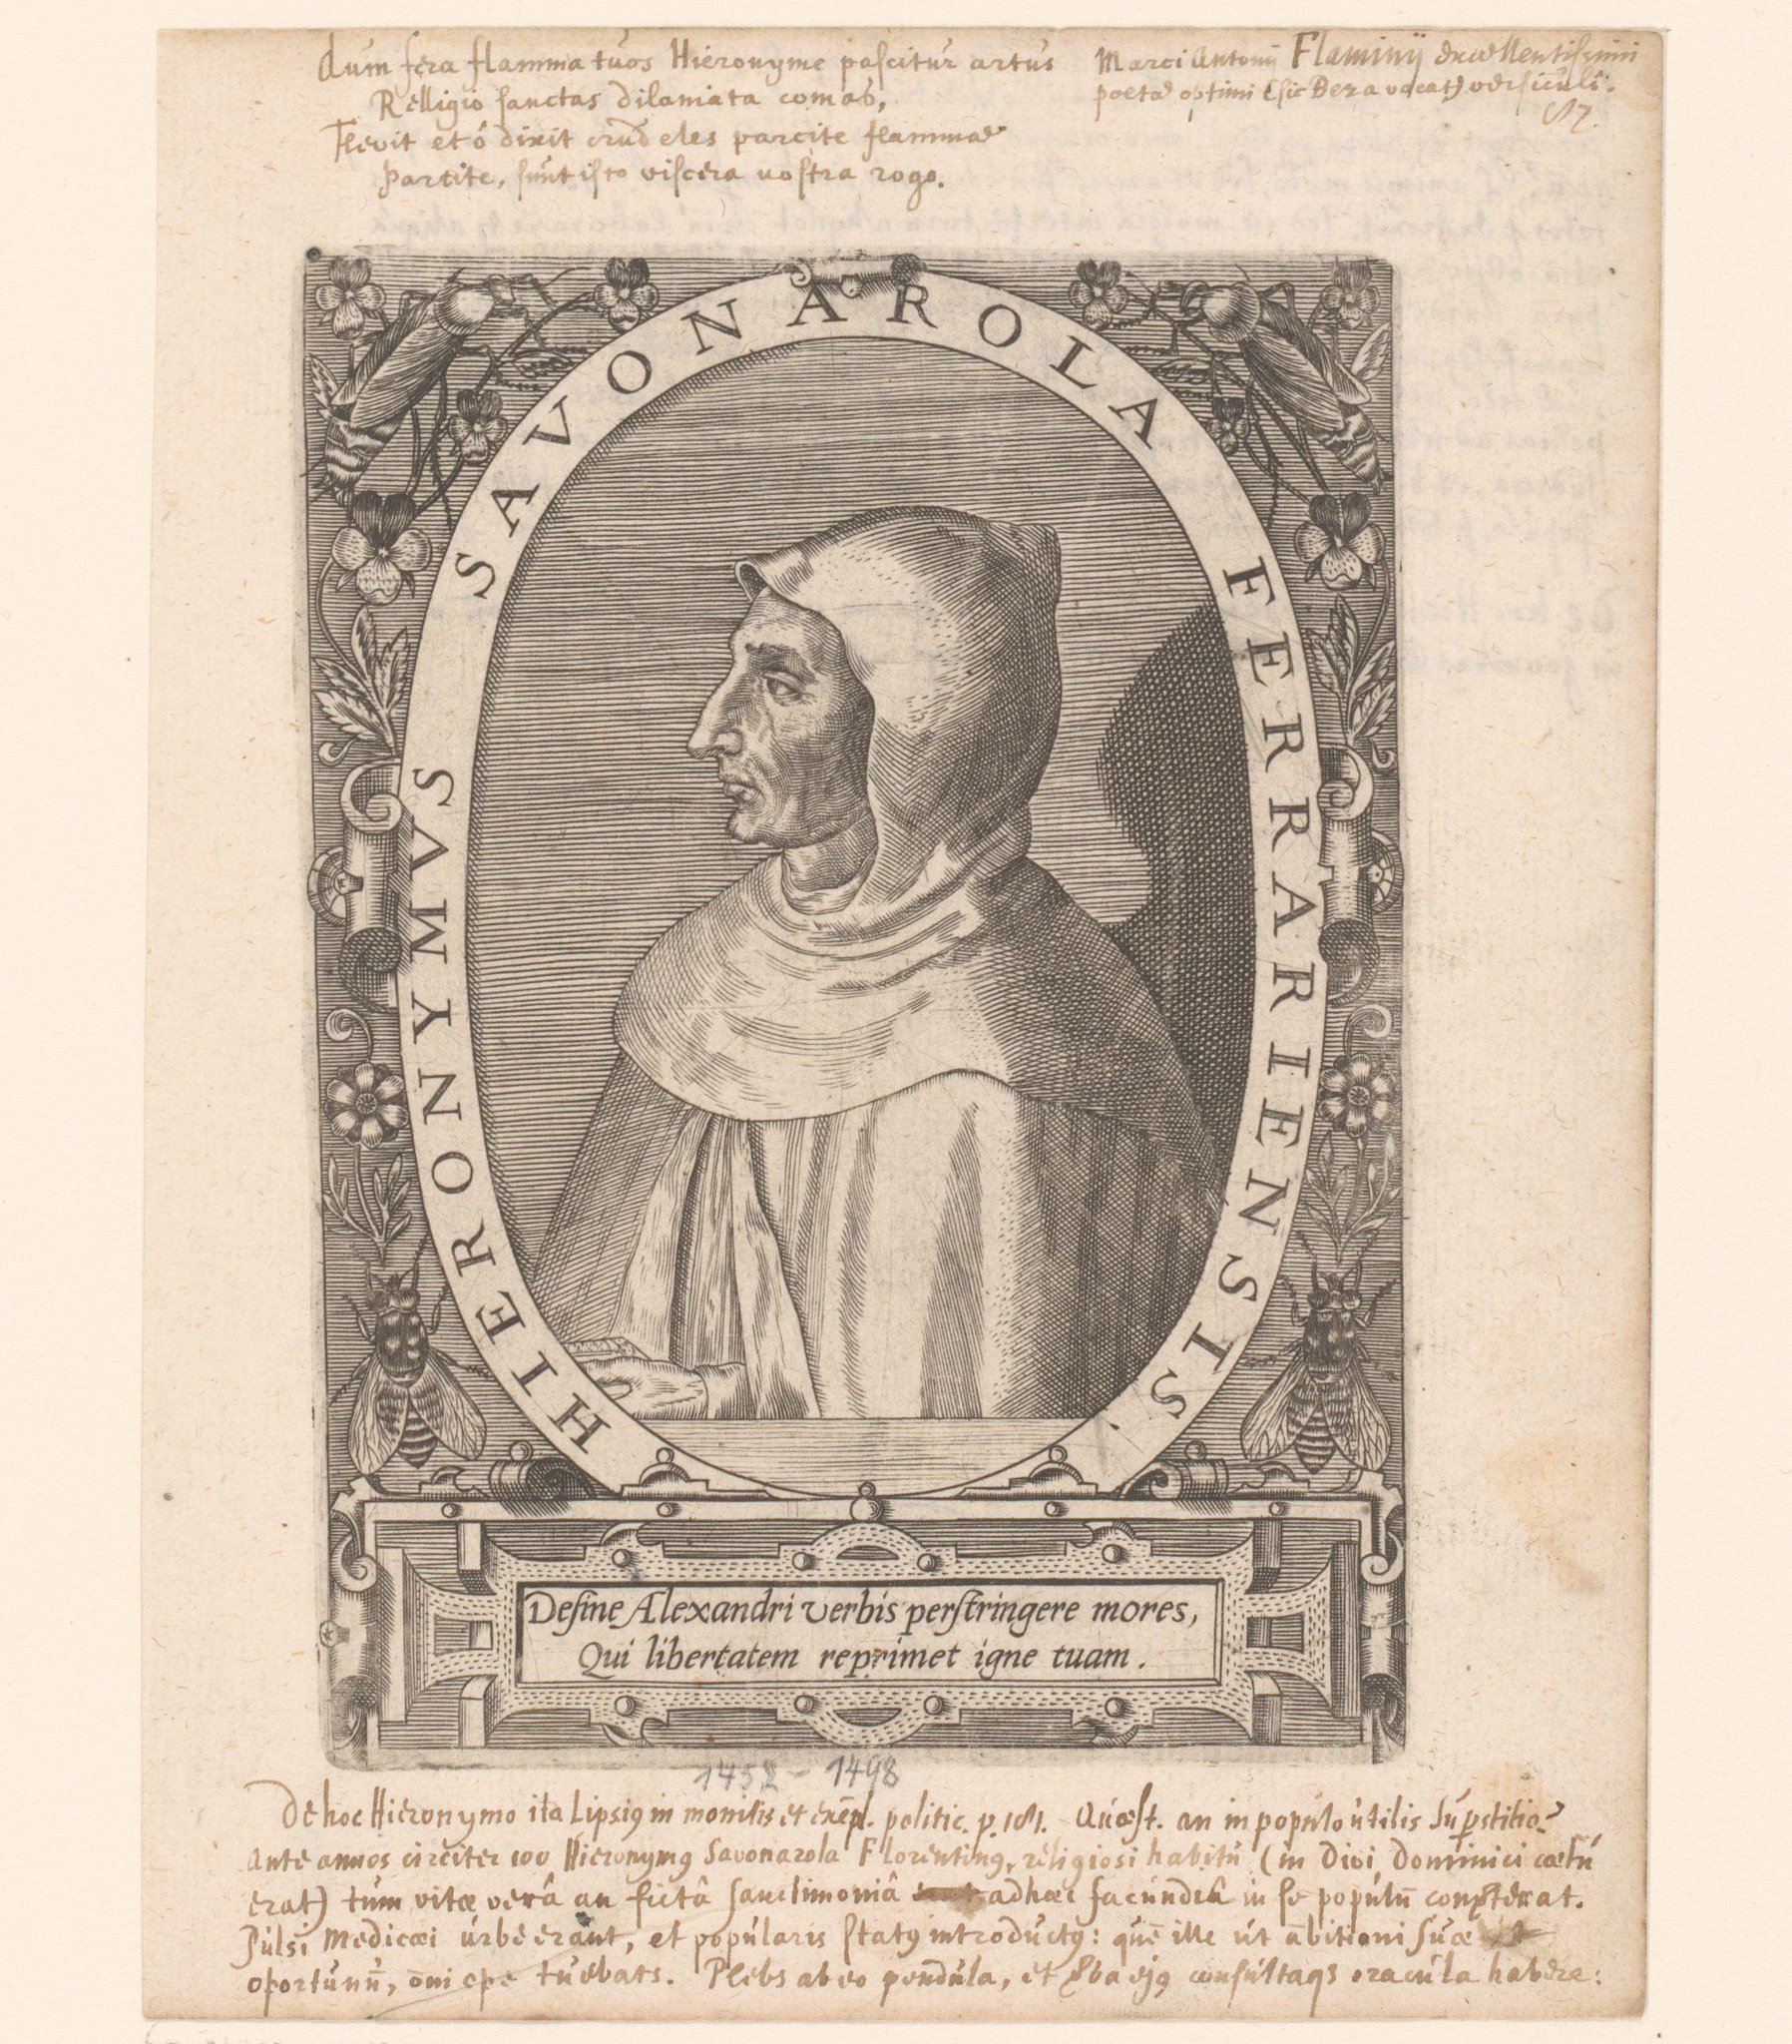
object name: print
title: Hieronymus Savonarola Ferrariensis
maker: robert boissard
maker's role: print maker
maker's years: 1570-1611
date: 1597-1599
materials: paper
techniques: engraving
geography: france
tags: priest, politician, historical persons, insects: fly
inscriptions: inscription: ‘Ipsi optimatus (...)’, inscription: ‘De hoc Hironymo ita Lipsig in (...)’, collector's mark: Lugt 2228